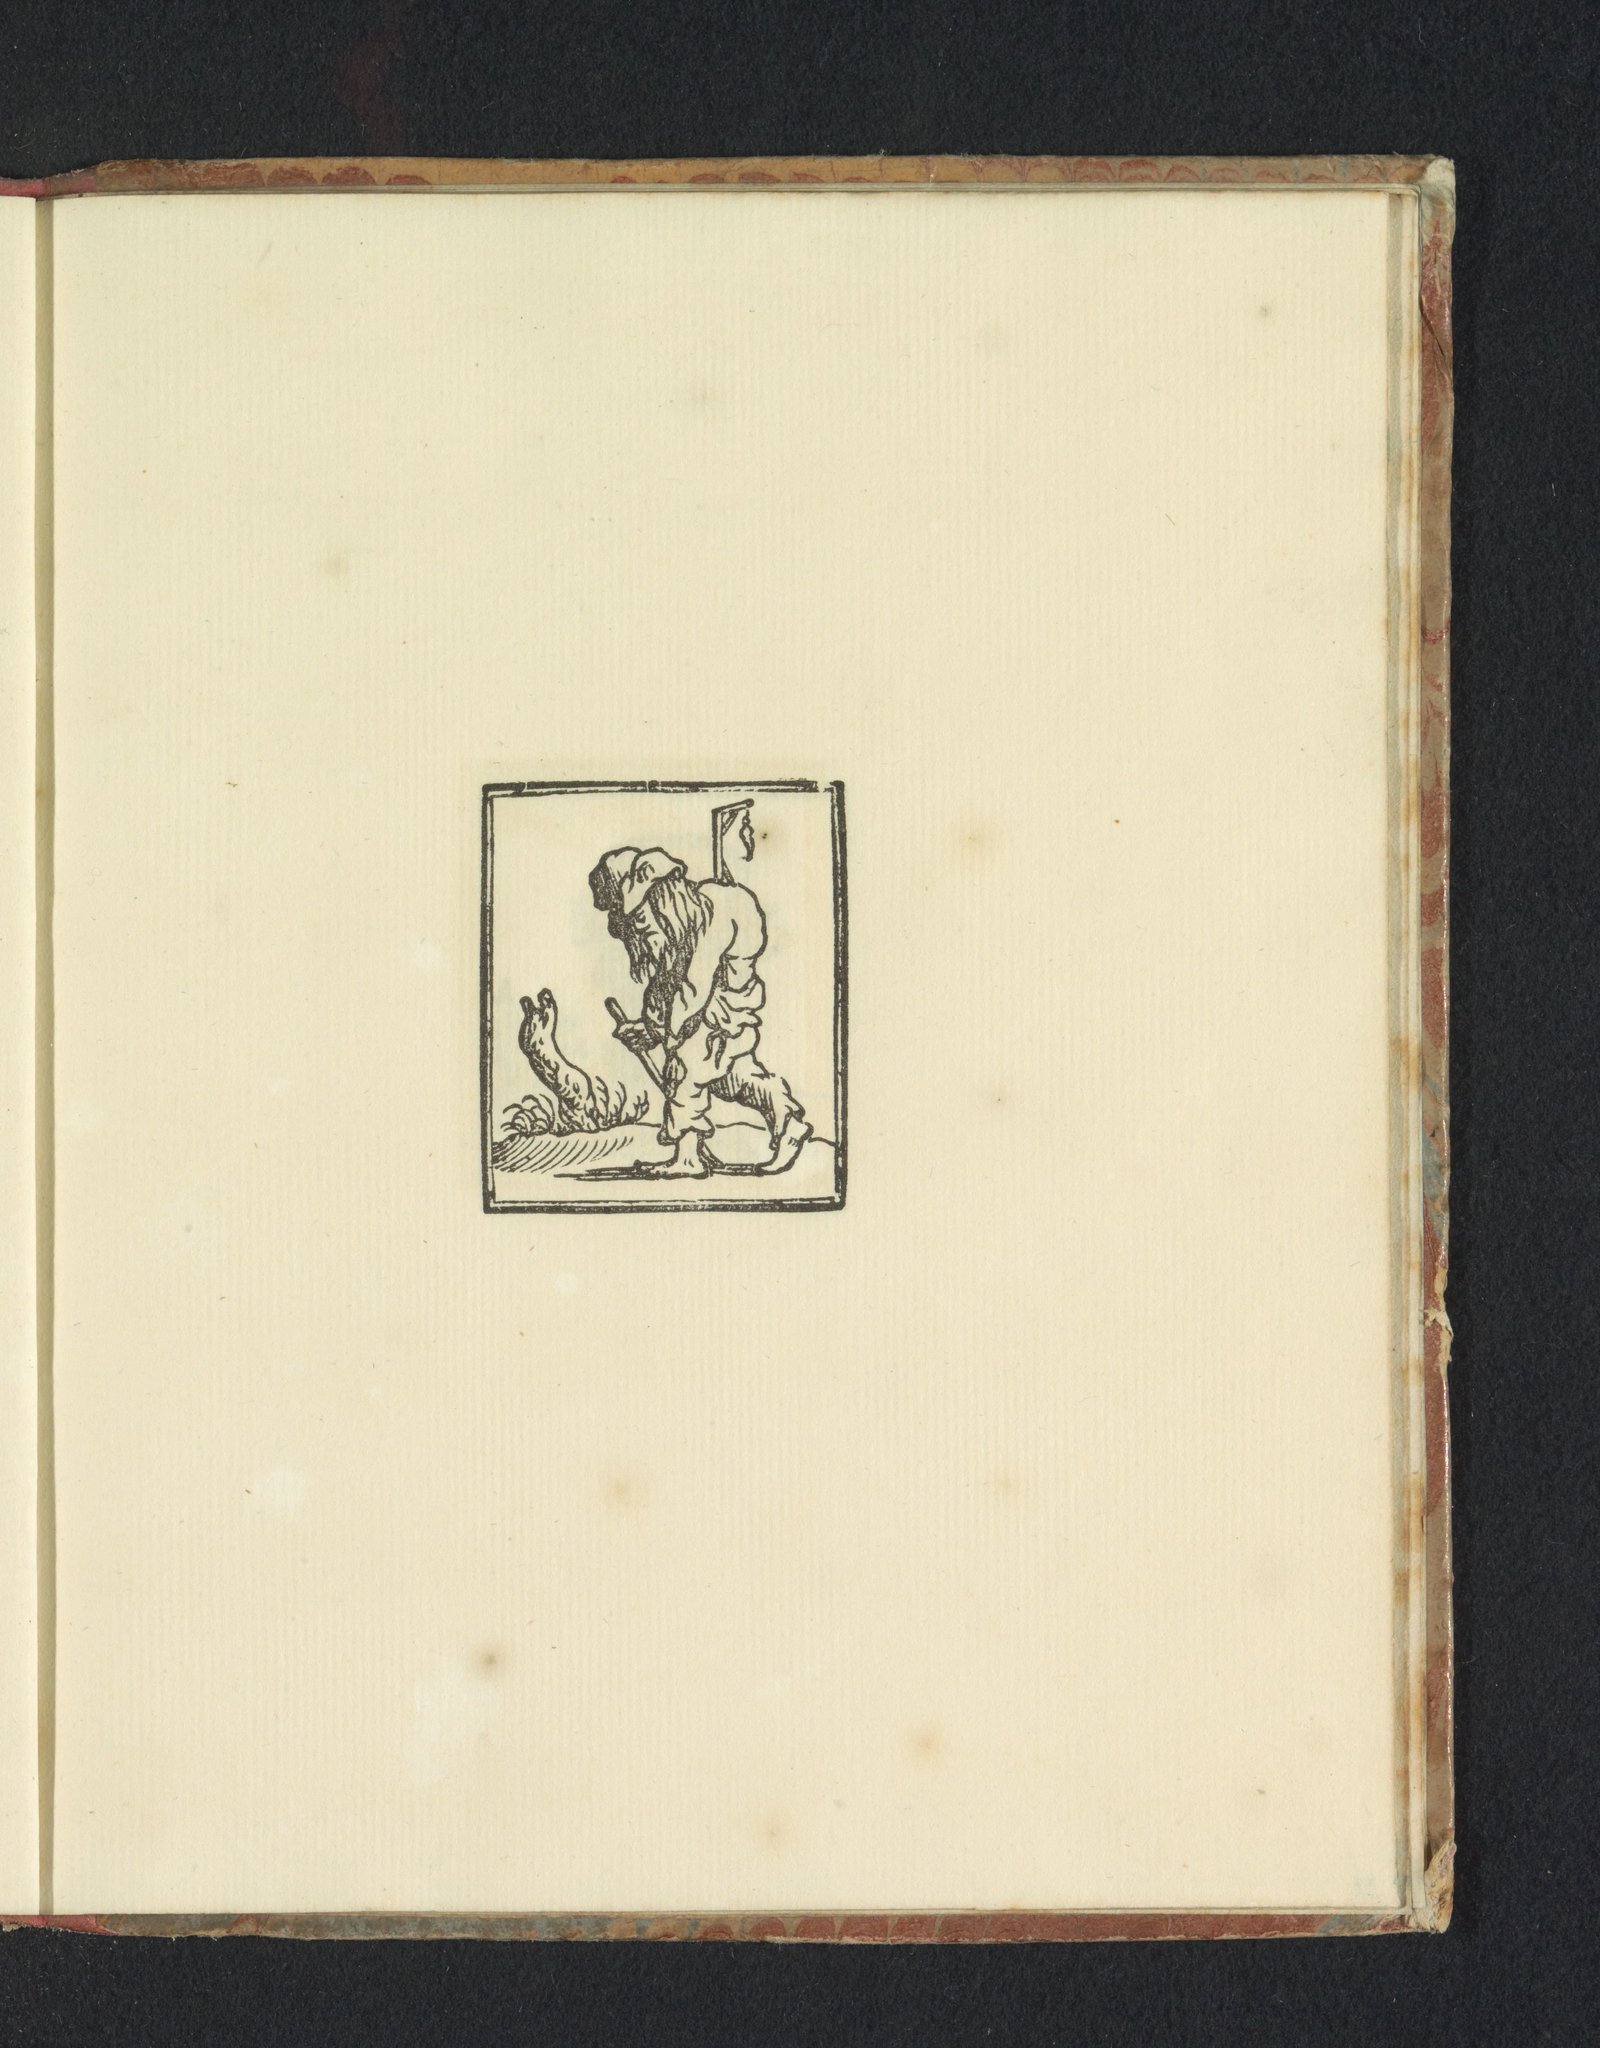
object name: popular print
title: Hangebast van Volewijk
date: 1731-1732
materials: paper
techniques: woodcut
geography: haarlem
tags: caricatures (human types)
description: Koddige figuur, in het onderschrift in de overzichtsprent draagt deze figuur de naam: Hangebast van Volewijk. Onderdeel van het boekje: XXXVI. aartige figuuren, geinventeert door Izaak van Ostade tot Haarlem [1731-1732].